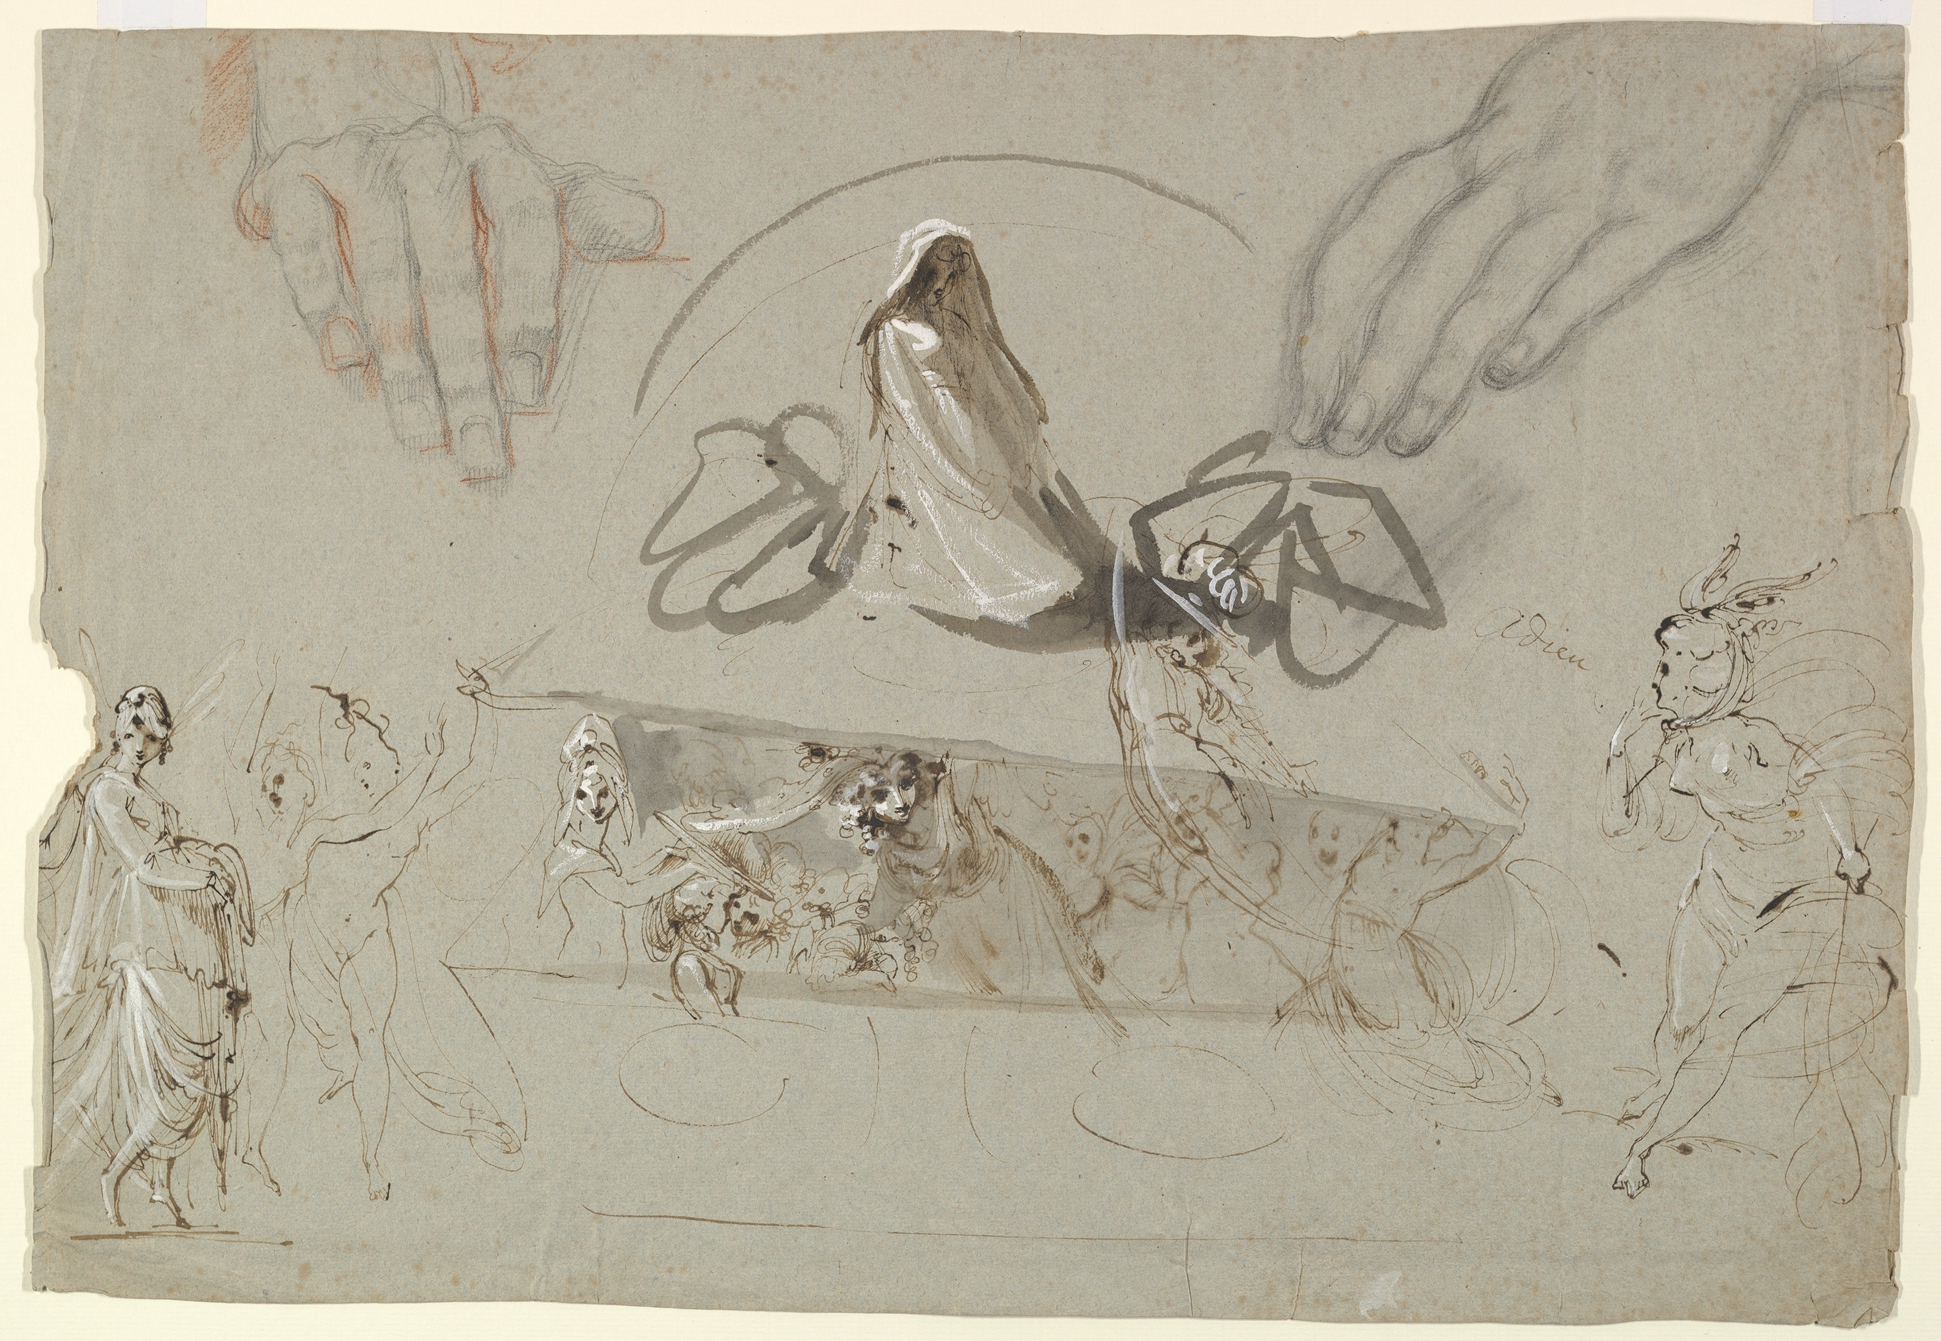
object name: drawing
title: Studies of fairies with a pair of hands (possibly representing the Opening of Pandora's Box)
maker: william lock the younger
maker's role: artist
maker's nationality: british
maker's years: 1767-1847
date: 1784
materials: chalk, gouache, graphite, ink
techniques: brush, pen, wash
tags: hands,women